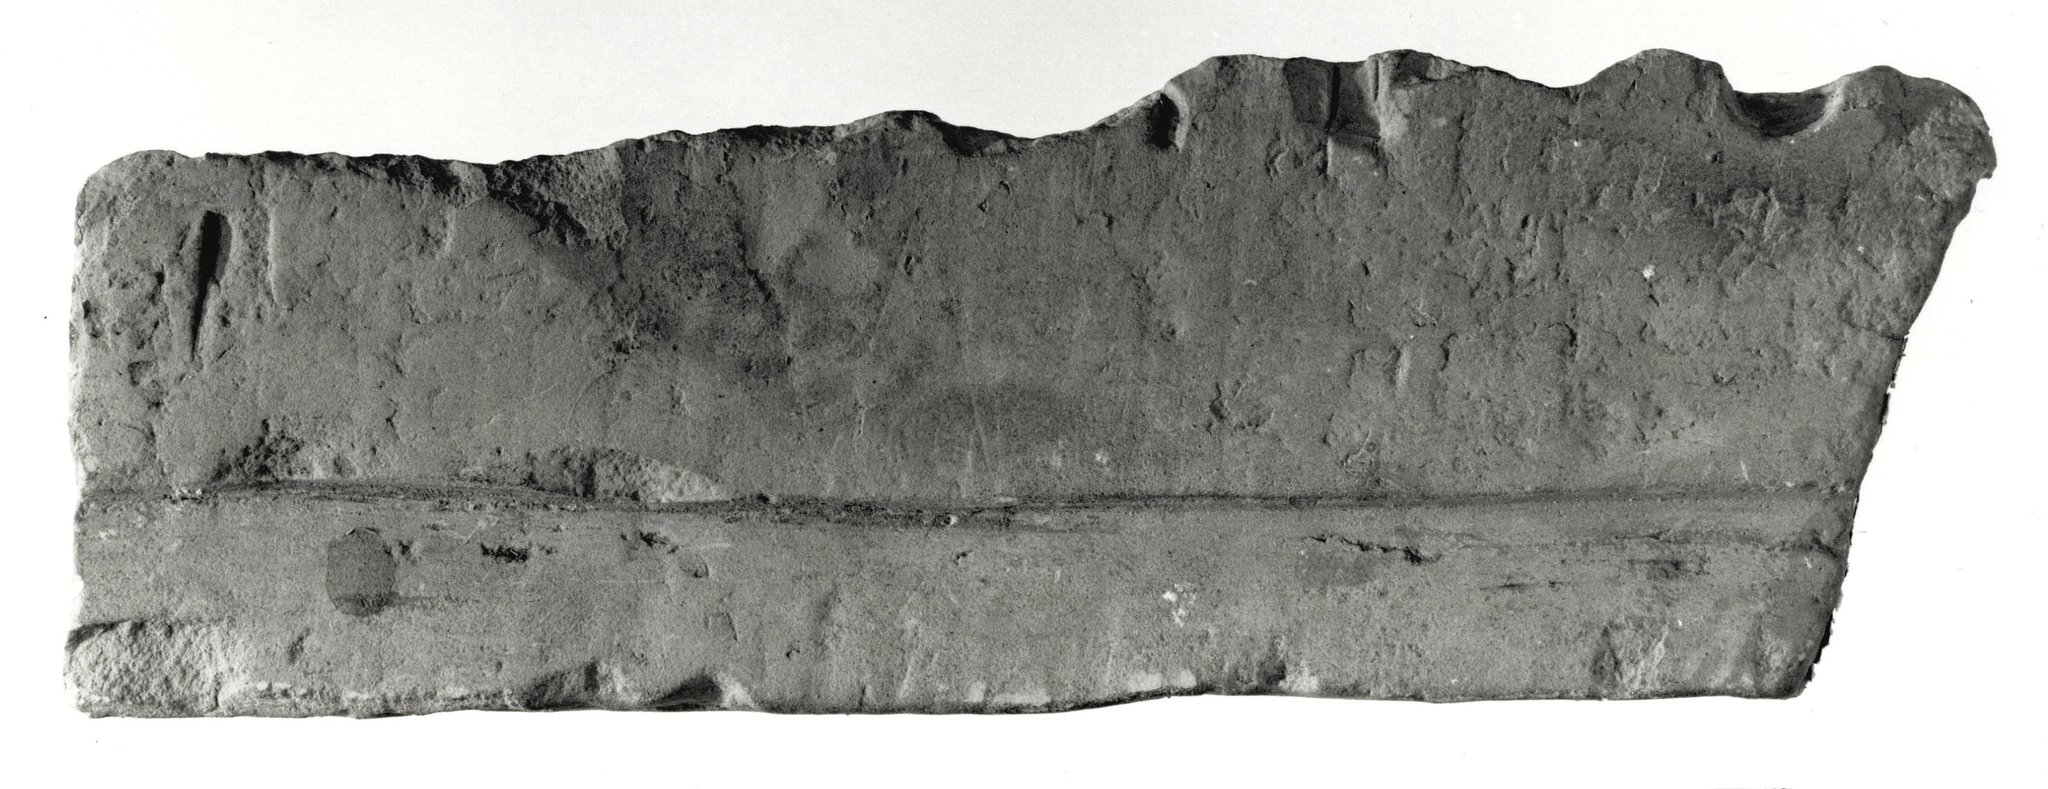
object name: relief, tomb of nespekashuty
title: Raised relief fragment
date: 664-610 BCE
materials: limestone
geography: egypt